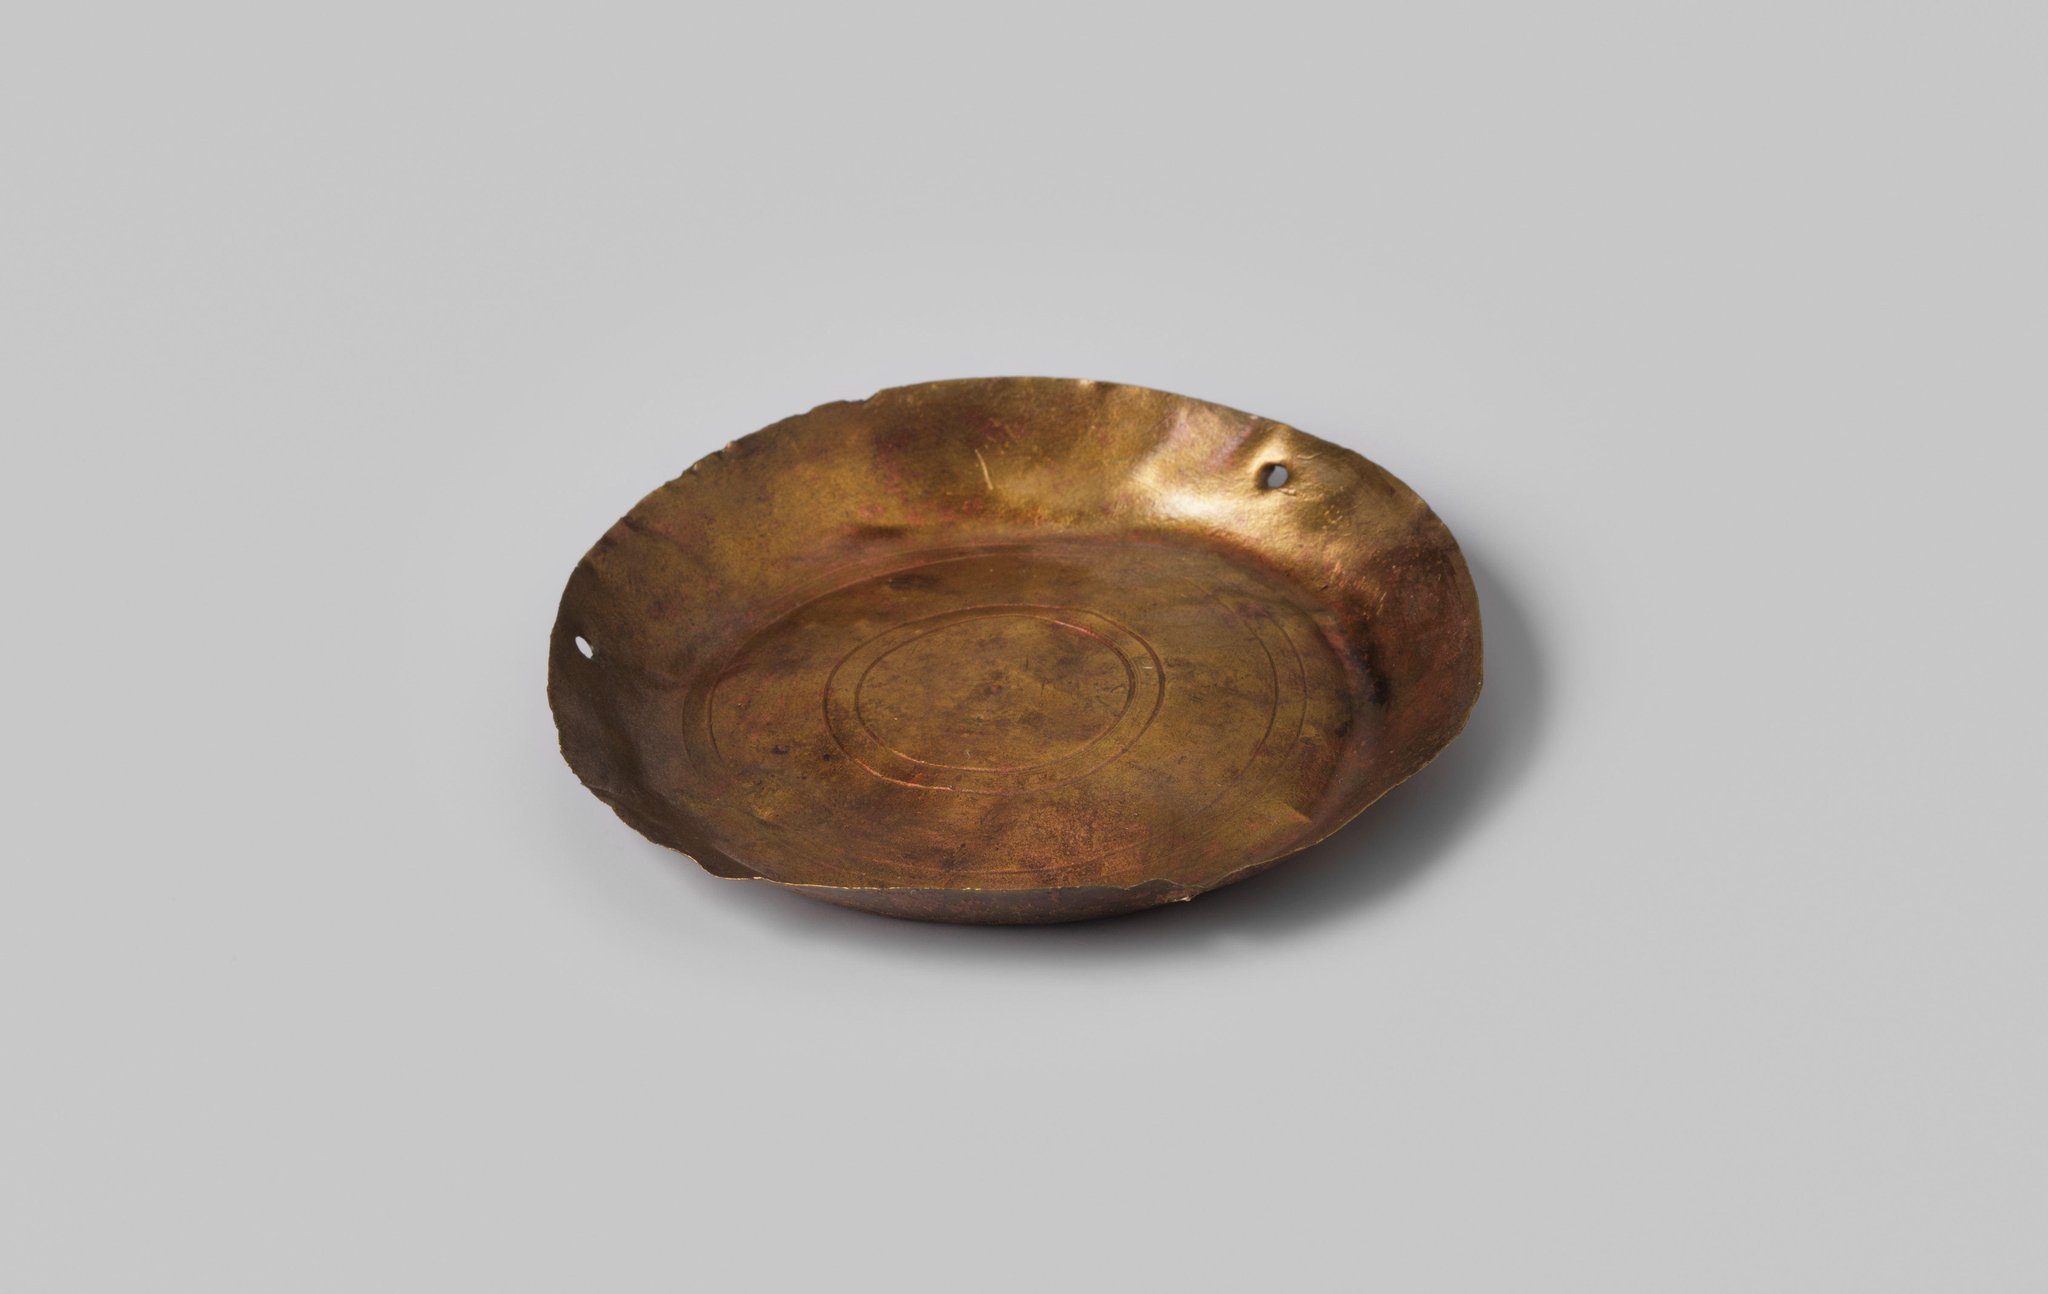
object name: weegschaal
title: Part of a weighing scale from the wreck of the Dutch East India ship Hollandia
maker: Anonymous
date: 1700-1743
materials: copper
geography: netherlands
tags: verenigde oostindische compagnie, hollandia (schip), annet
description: Weighing scales, pan; circular, shallow dish with everted rim, bottom slightly convex with engraved concentric circles, 3 eyes in rim.